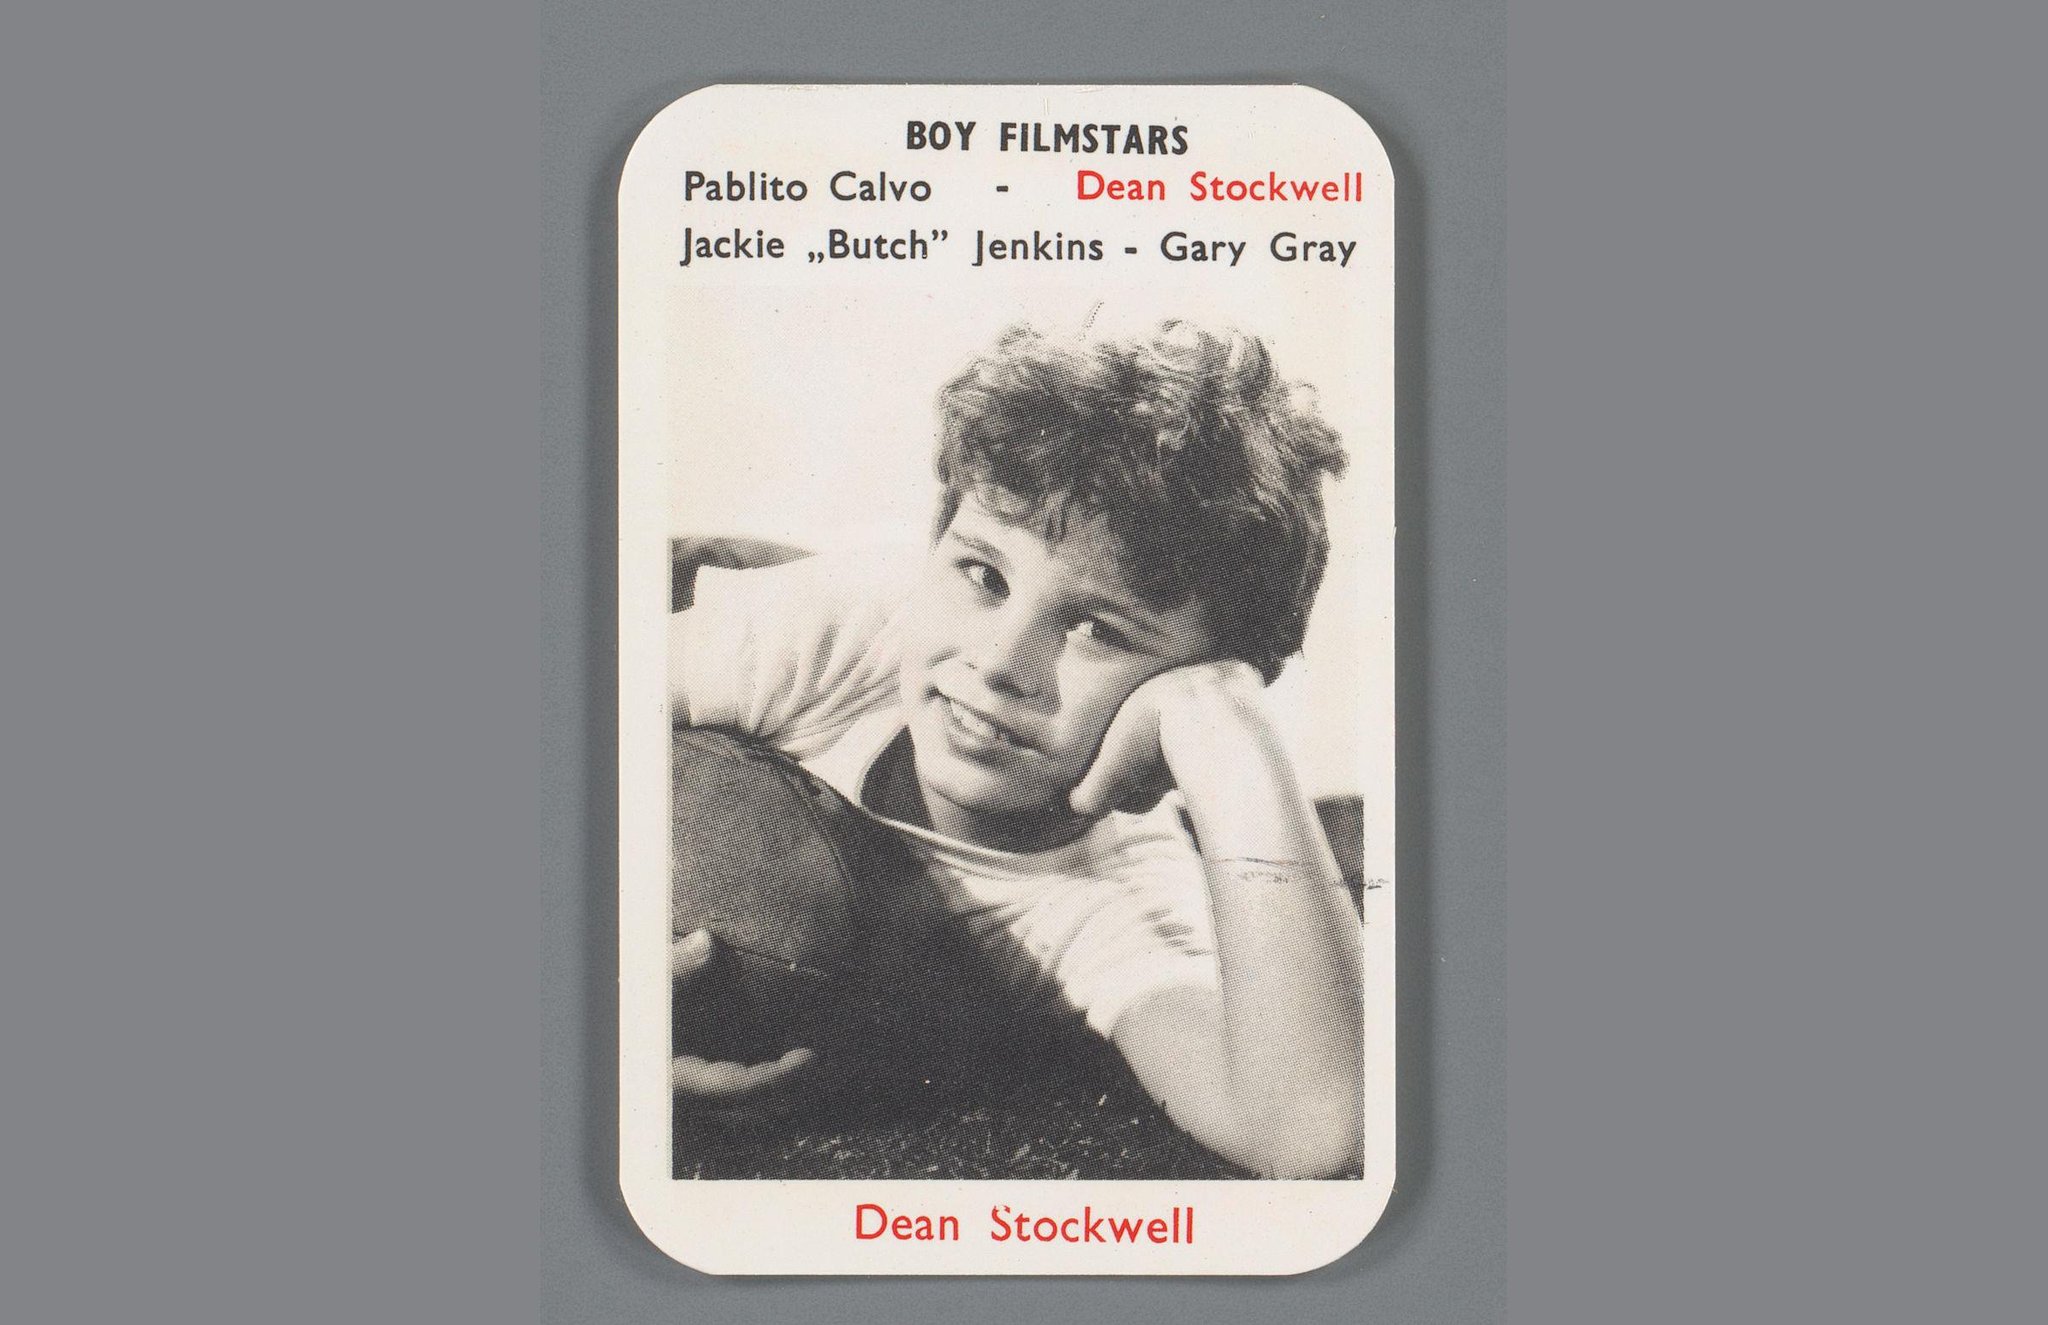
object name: playing card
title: Boy Filmstars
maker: Anonymous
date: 1960-1970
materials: paper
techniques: autotype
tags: portrait of actor, actress